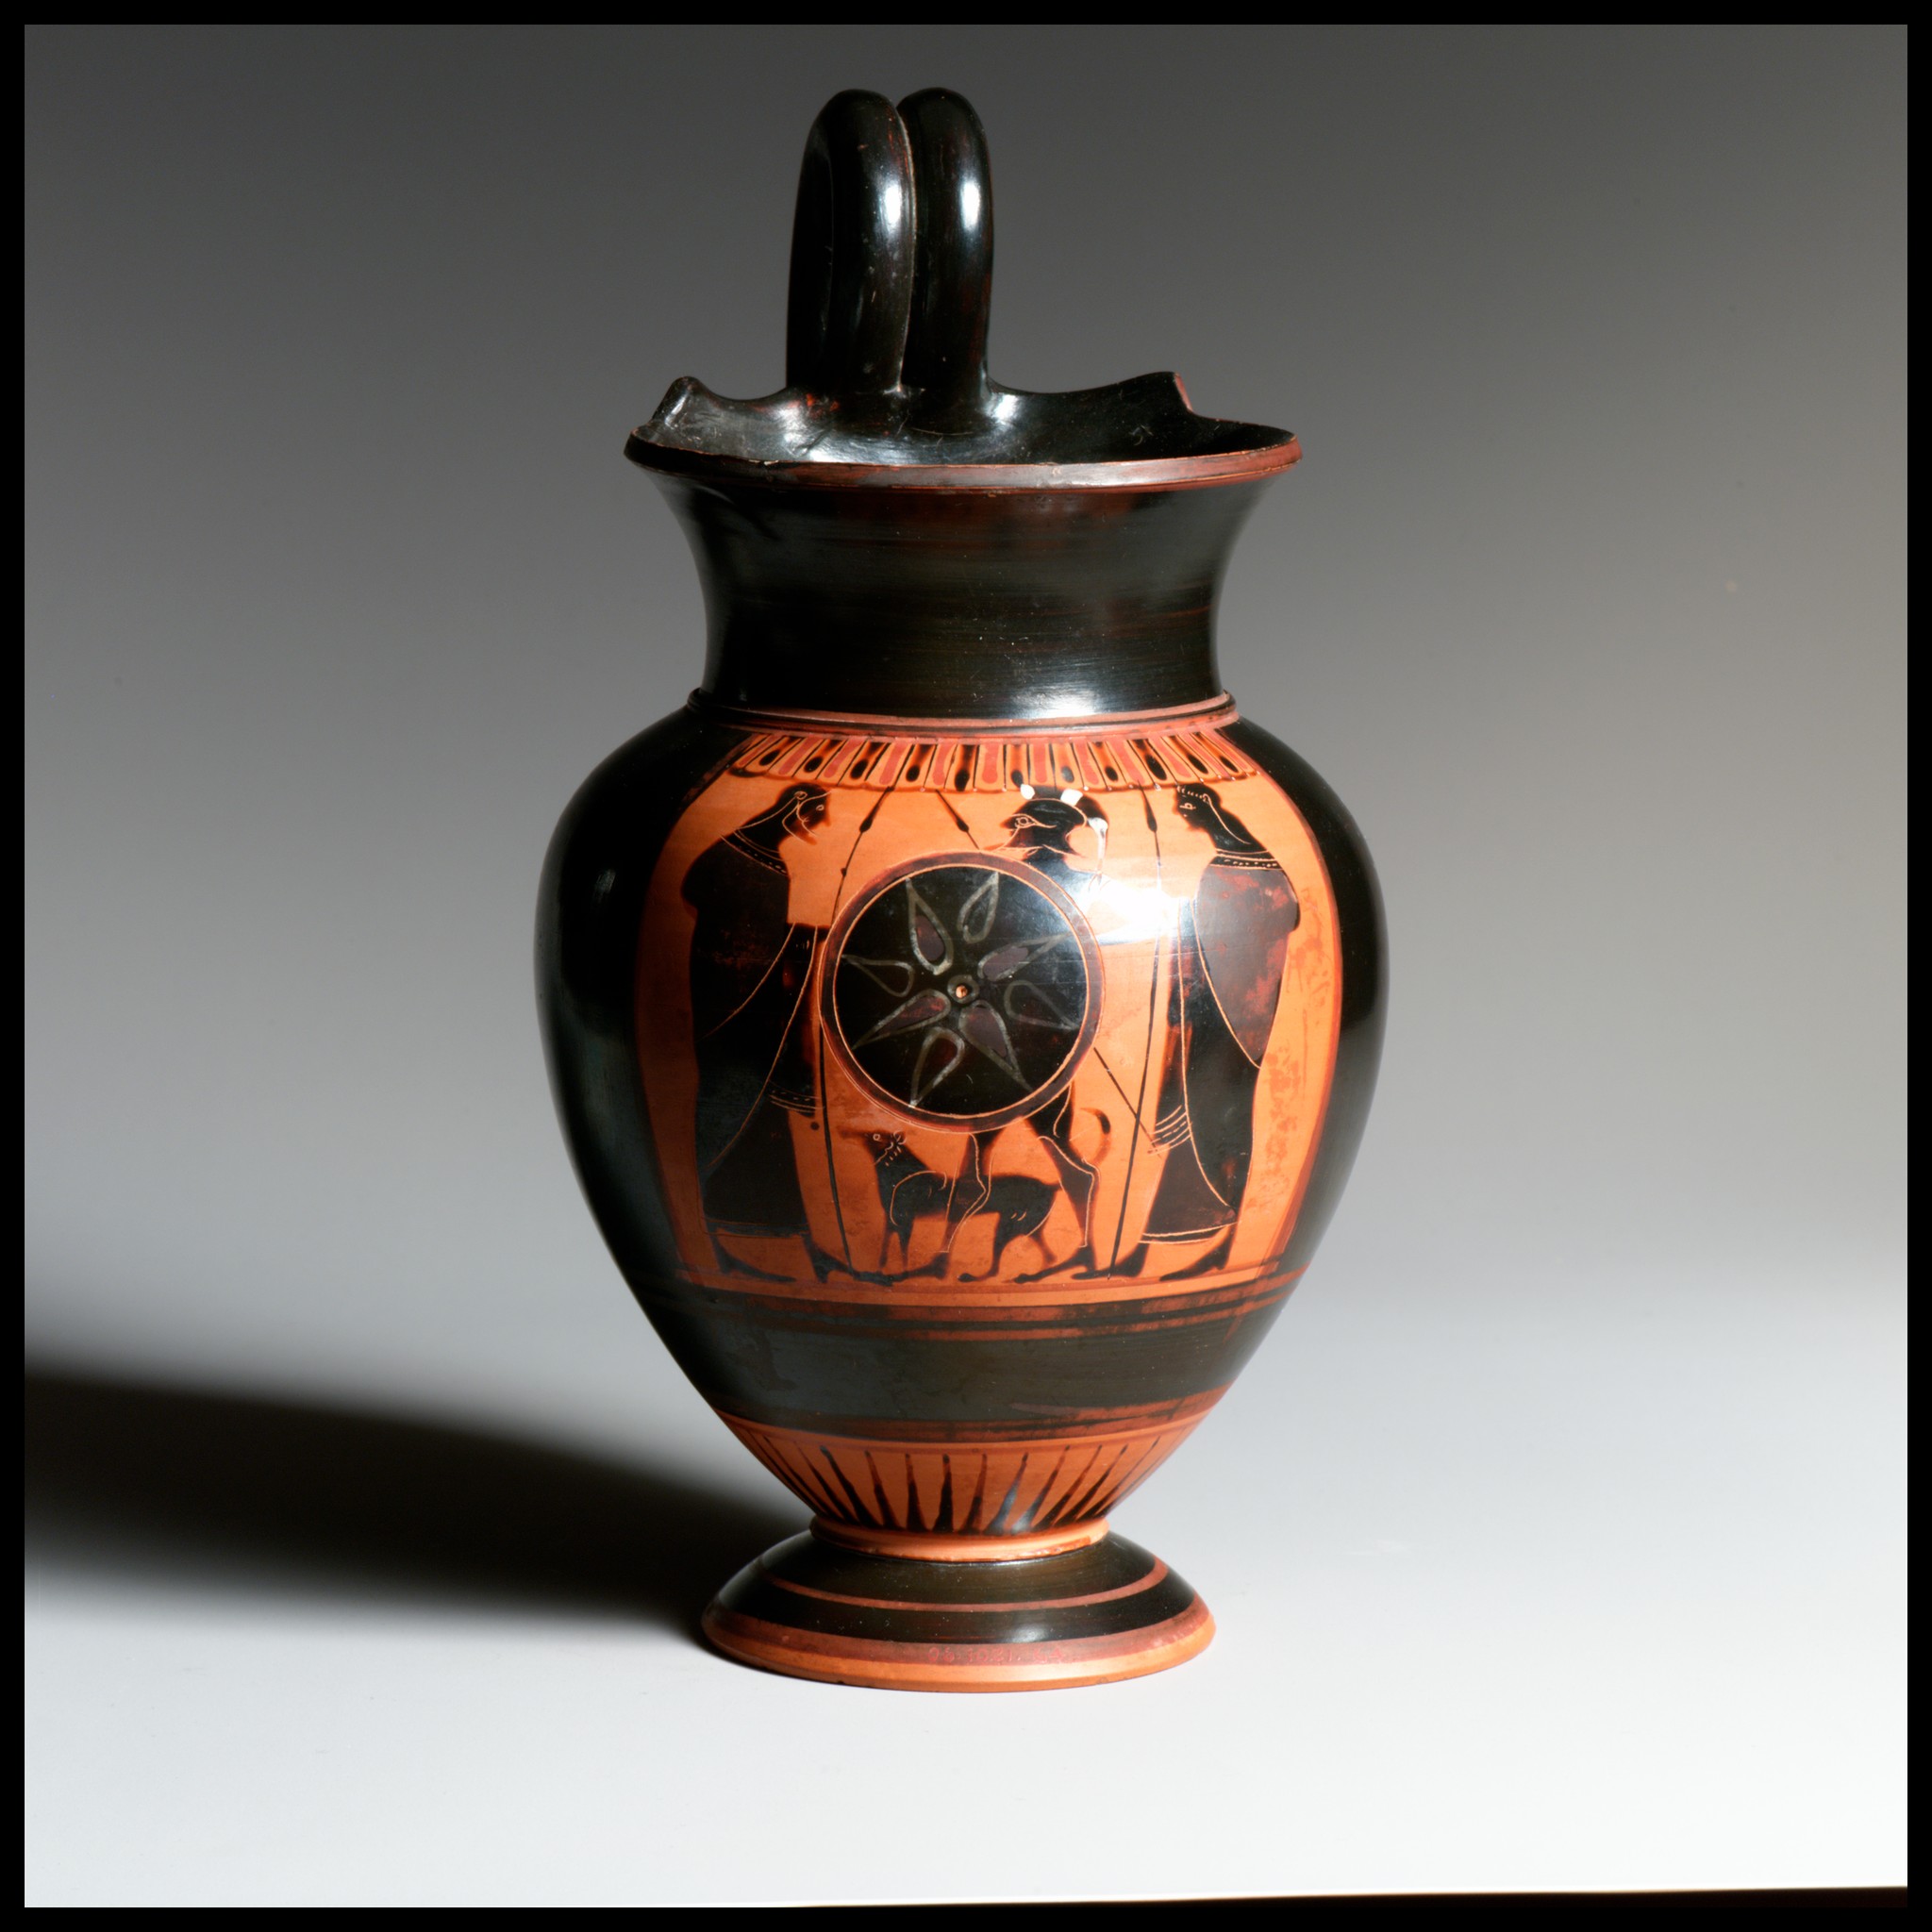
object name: oinochoe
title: Terracotta oinochoe (jug)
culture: greek, attic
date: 550 BCE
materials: terracotta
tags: shields,men,dogs,warriors